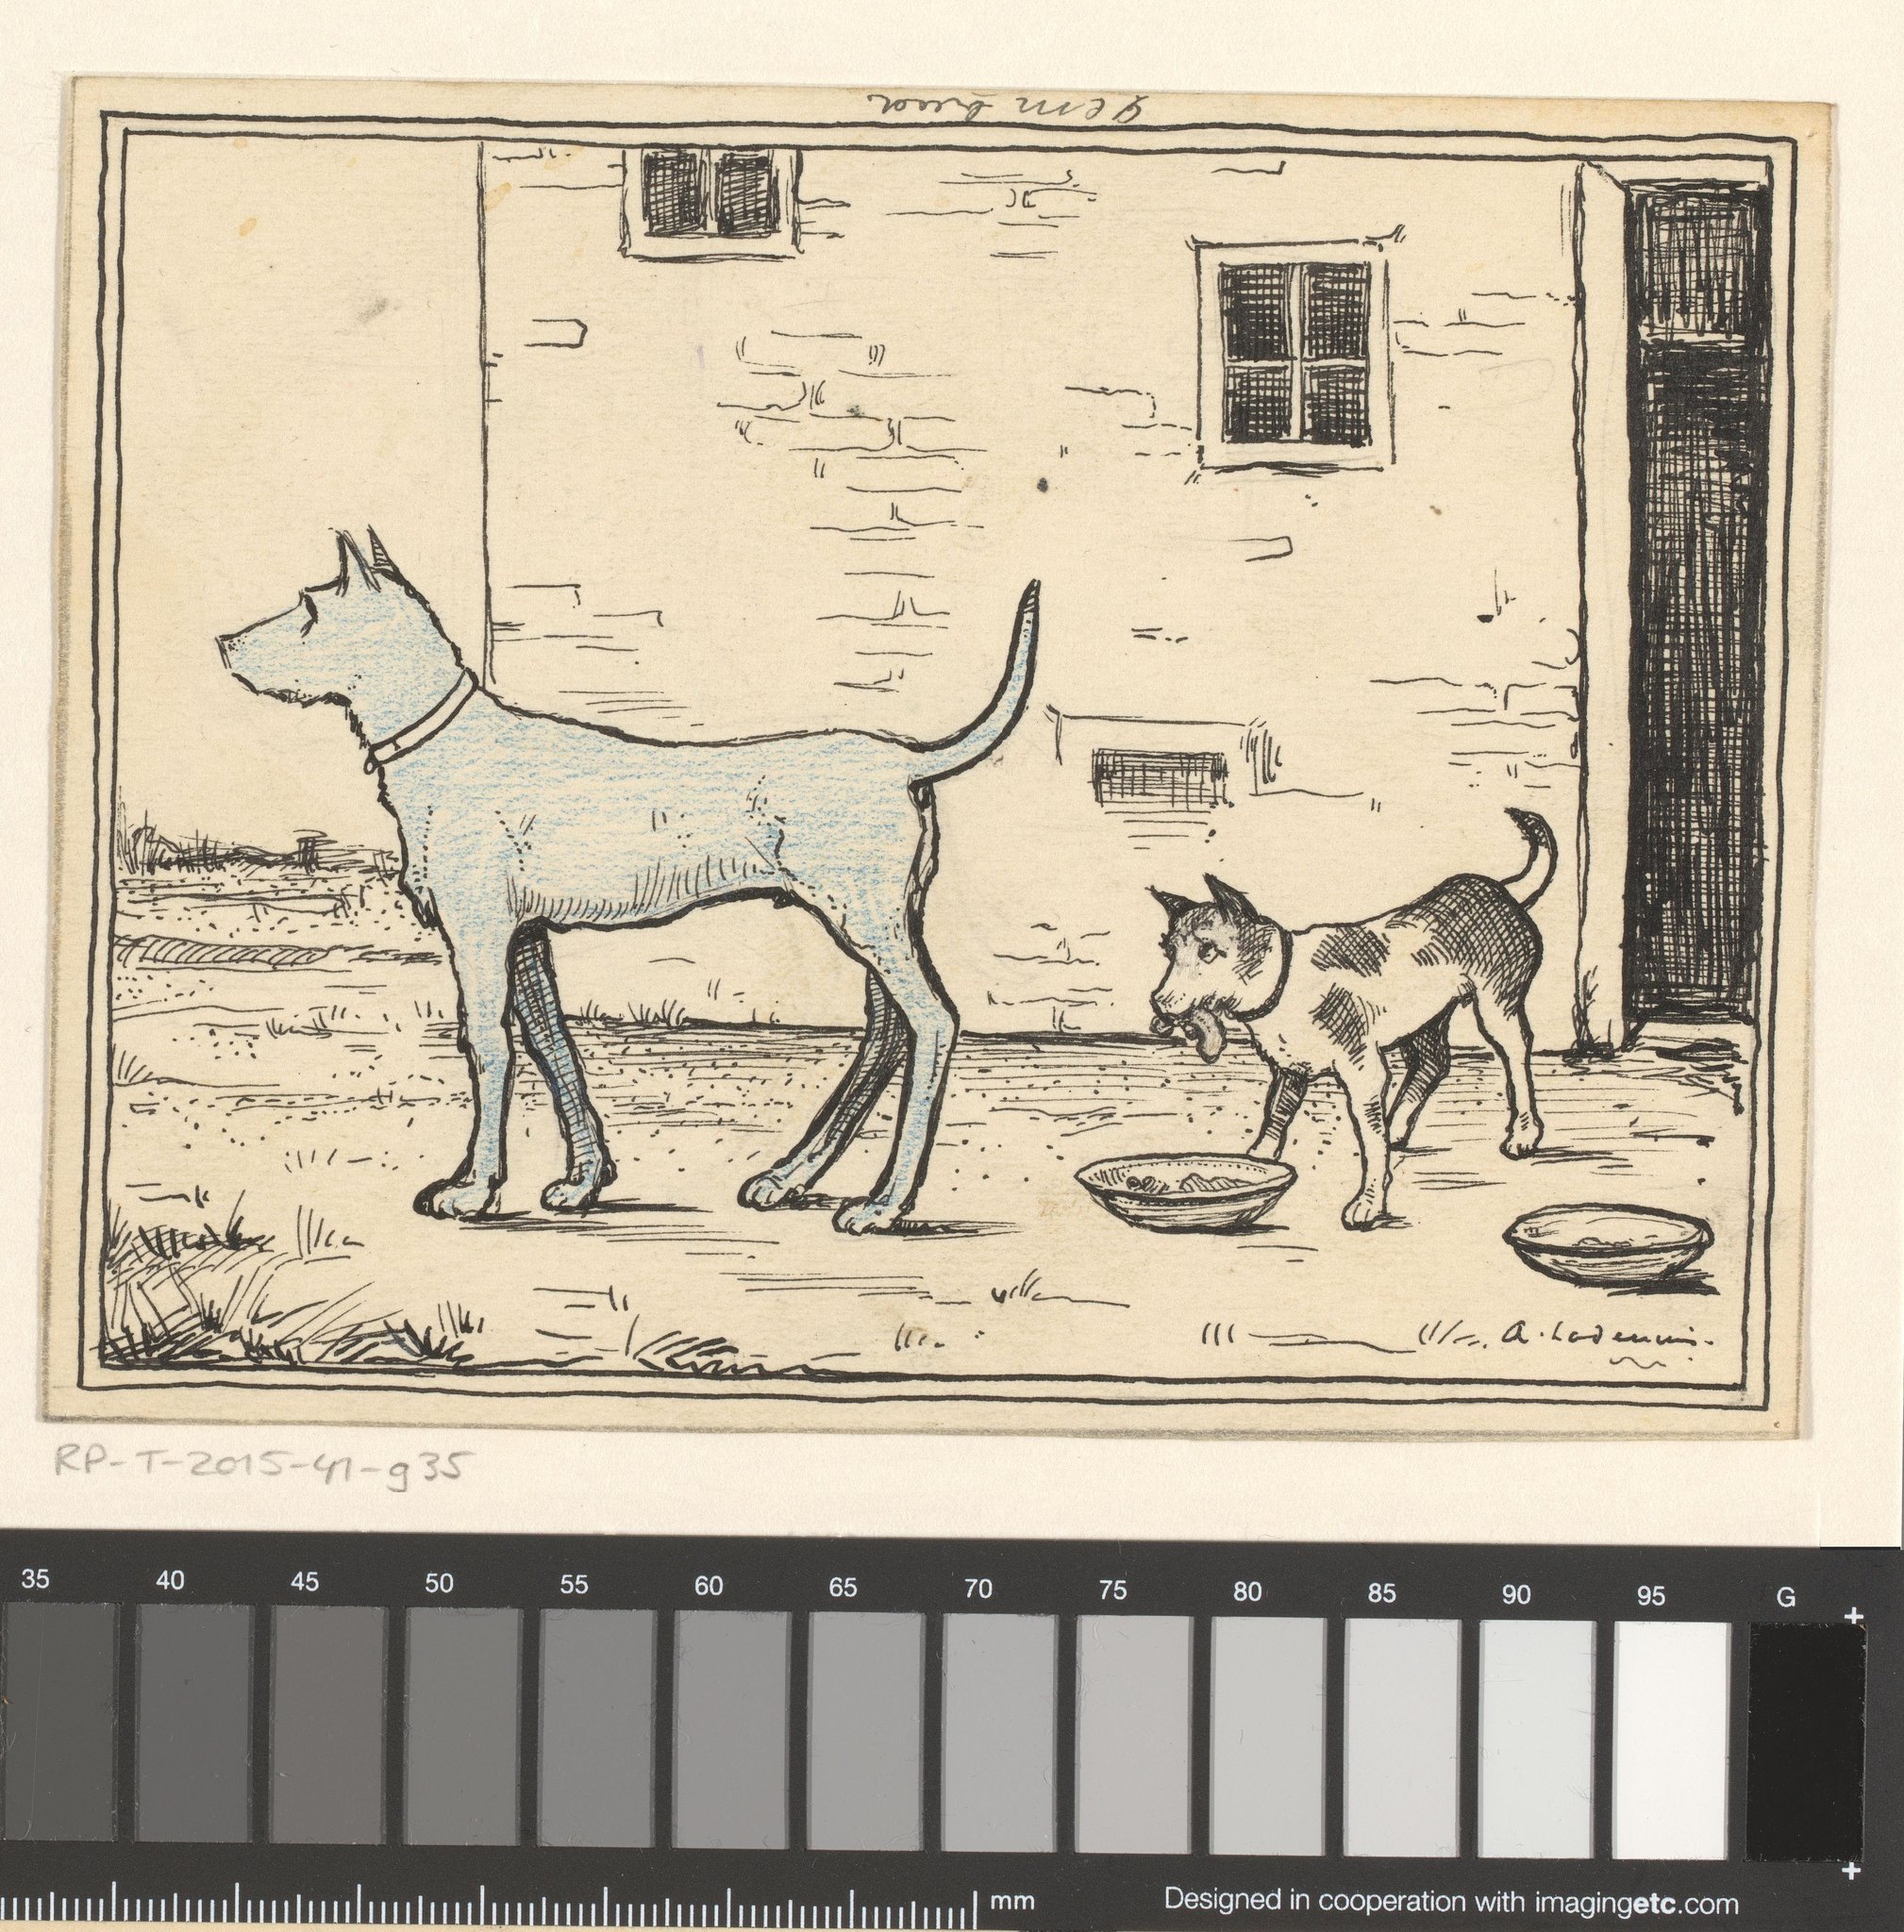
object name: boekillustratie ontwerp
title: Twee honden bij twee schotels met eten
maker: adri ladenius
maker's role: draughtsman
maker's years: 1883-1953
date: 1910-1940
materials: ink, paper, pencil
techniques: pen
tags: dog (+ feeding animal), sausage, dog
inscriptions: signature: ‘A. Ladenius.’, collector's mark: Lugt 2228, :, annotation: ‘Ons Thuis/ Nero & Fox/ Augustus IV’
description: Twee honden staan bij een buitenmuur van een huis. Op de grond staan twee schotels met eten. Eén van de honden heeft een worst in de bek.